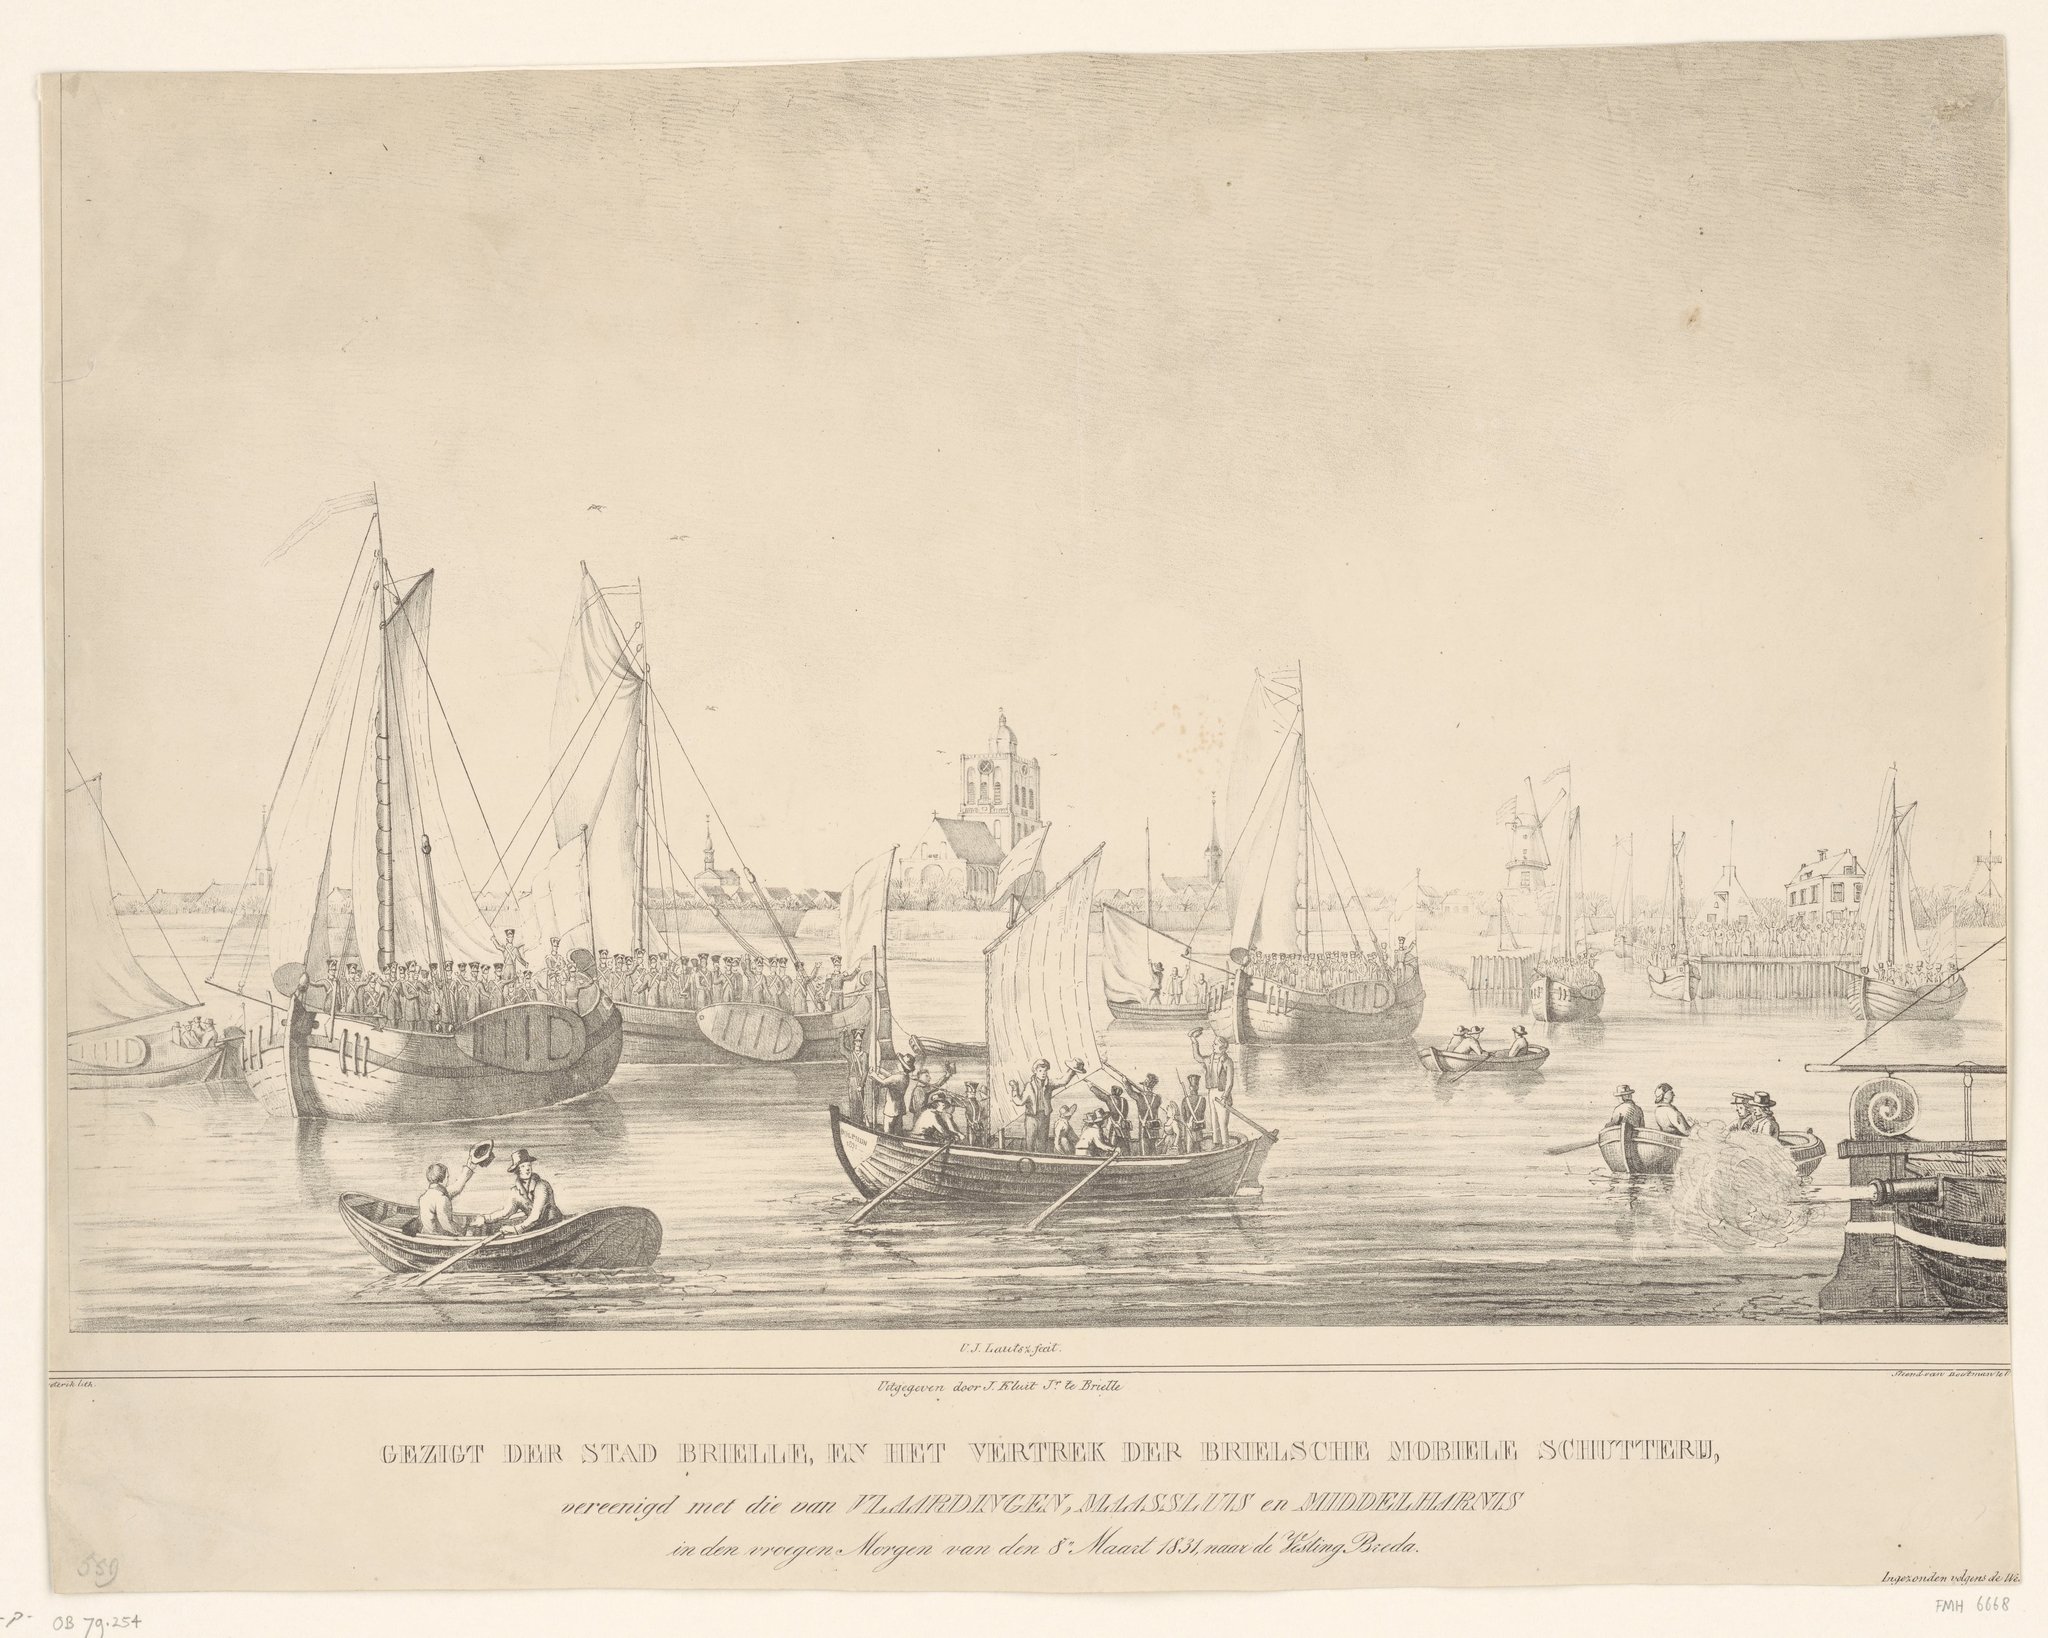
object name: print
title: Gezigt der stad Brielle, en het vertrek der Brielsche Mobiele Schutterij, vereenigd met die van Vlaardingen, Maassluis en Middelharnis in den vroegen Morgen van den 8. Maart 1831, naar de Vesting Breda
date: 1831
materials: paper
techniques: lithograph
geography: utrecht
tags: leave-taking (of soldiers), brielle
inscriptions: collector's mark: Lugt 2228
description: Gezicht op Brielle met het vertrek van de Brielsche Mobiele Schutterij onder commando van kapitein A.H. van Kruine, verenigd met de mobiele schutterijen van Vlaardingen, Maassluis en Middelharnis, naar de Vesting Breda, in de ochtend van 8 maart 1831. Vanuit de haven aan het Brielse Diep vertrekken meerder schuiten vol militairen, door een menigte op de pier uitgeleide gedaan.